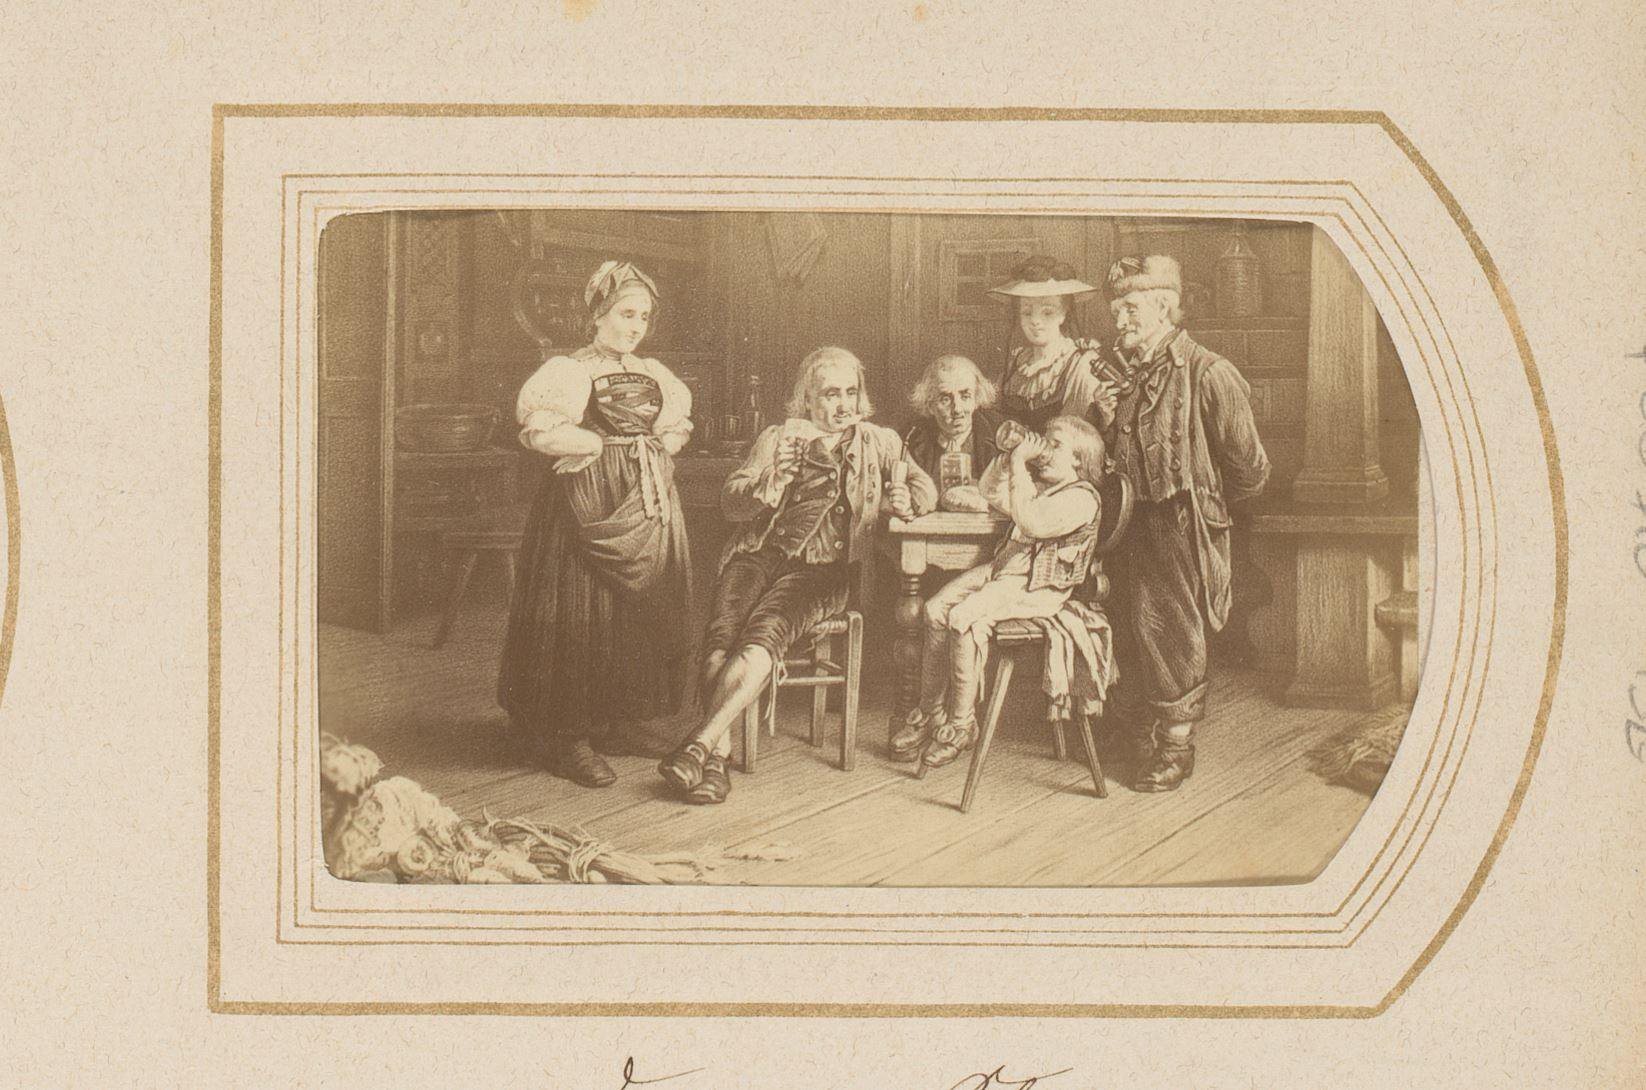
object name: reproduction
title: Fotoreproductie van Der erste Schoppen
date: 1870-1890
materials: cardboard, photographic support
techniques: albumen print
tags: beer, ale, family, descendance, painting, drawing and the graphic arts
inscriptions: annotation: ‘Den ersten Schoppen’, number: ‘603’